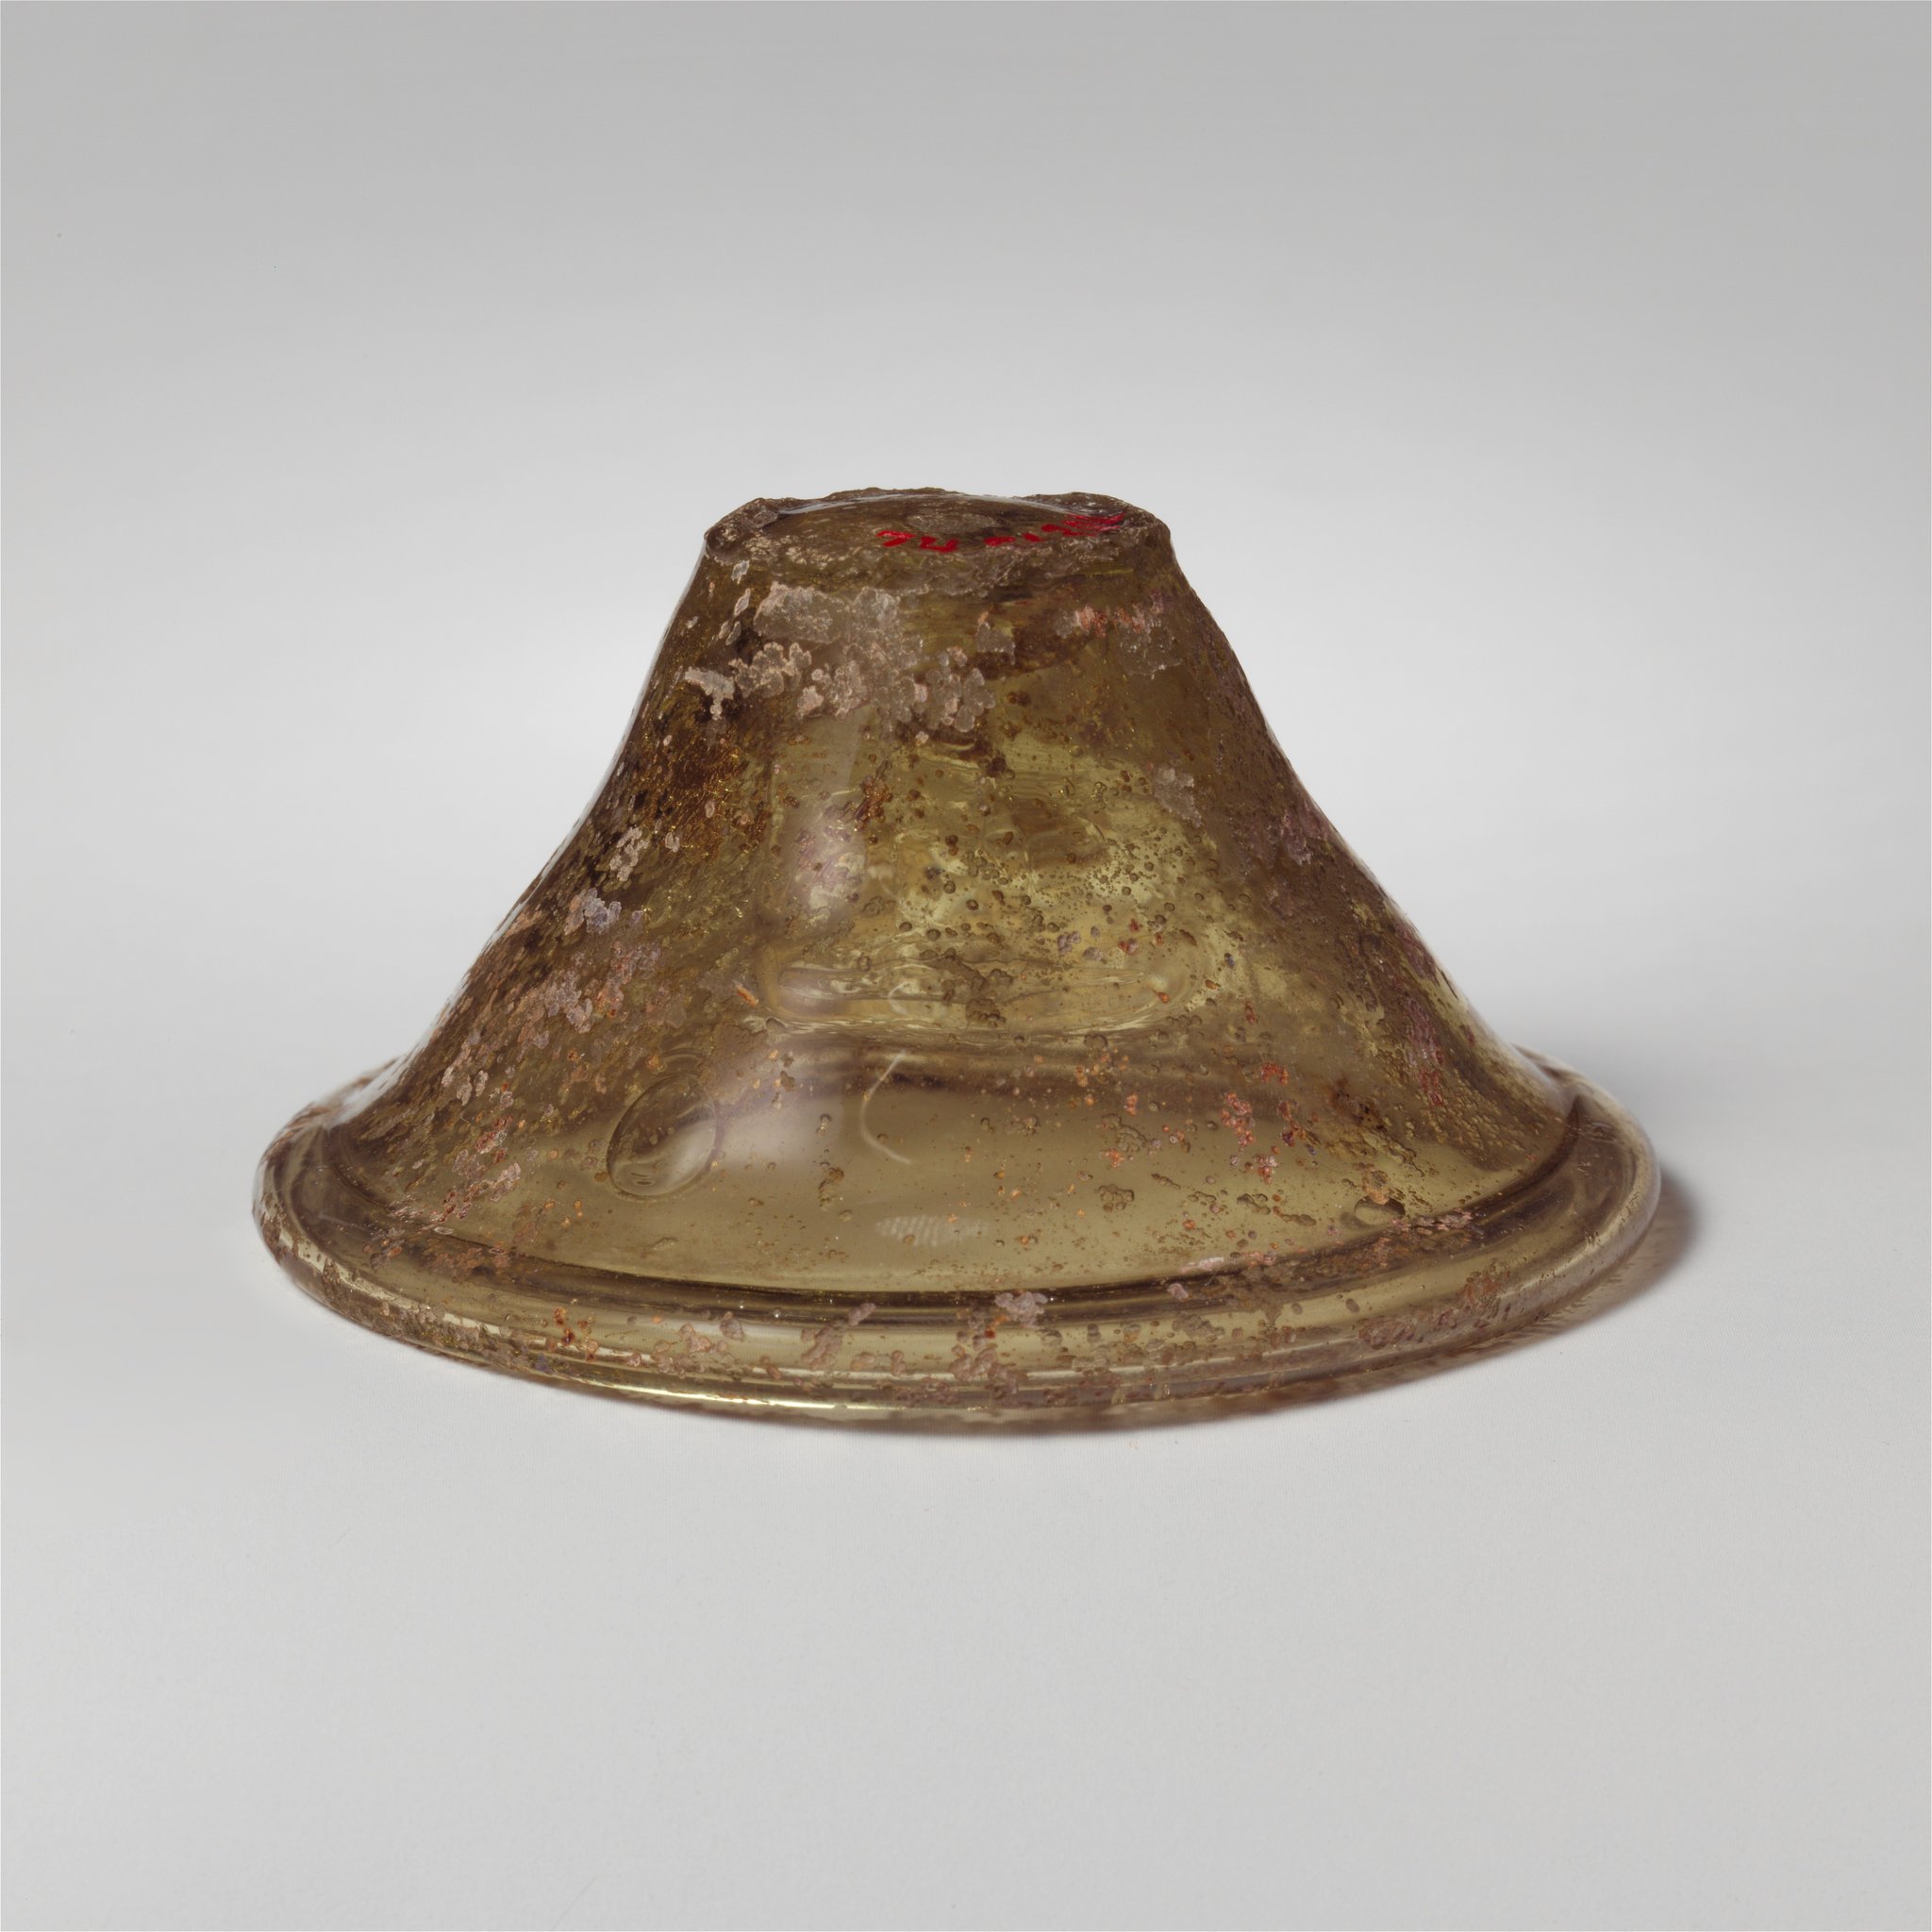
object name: base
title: Glass base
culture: roman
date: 201-400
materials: glass